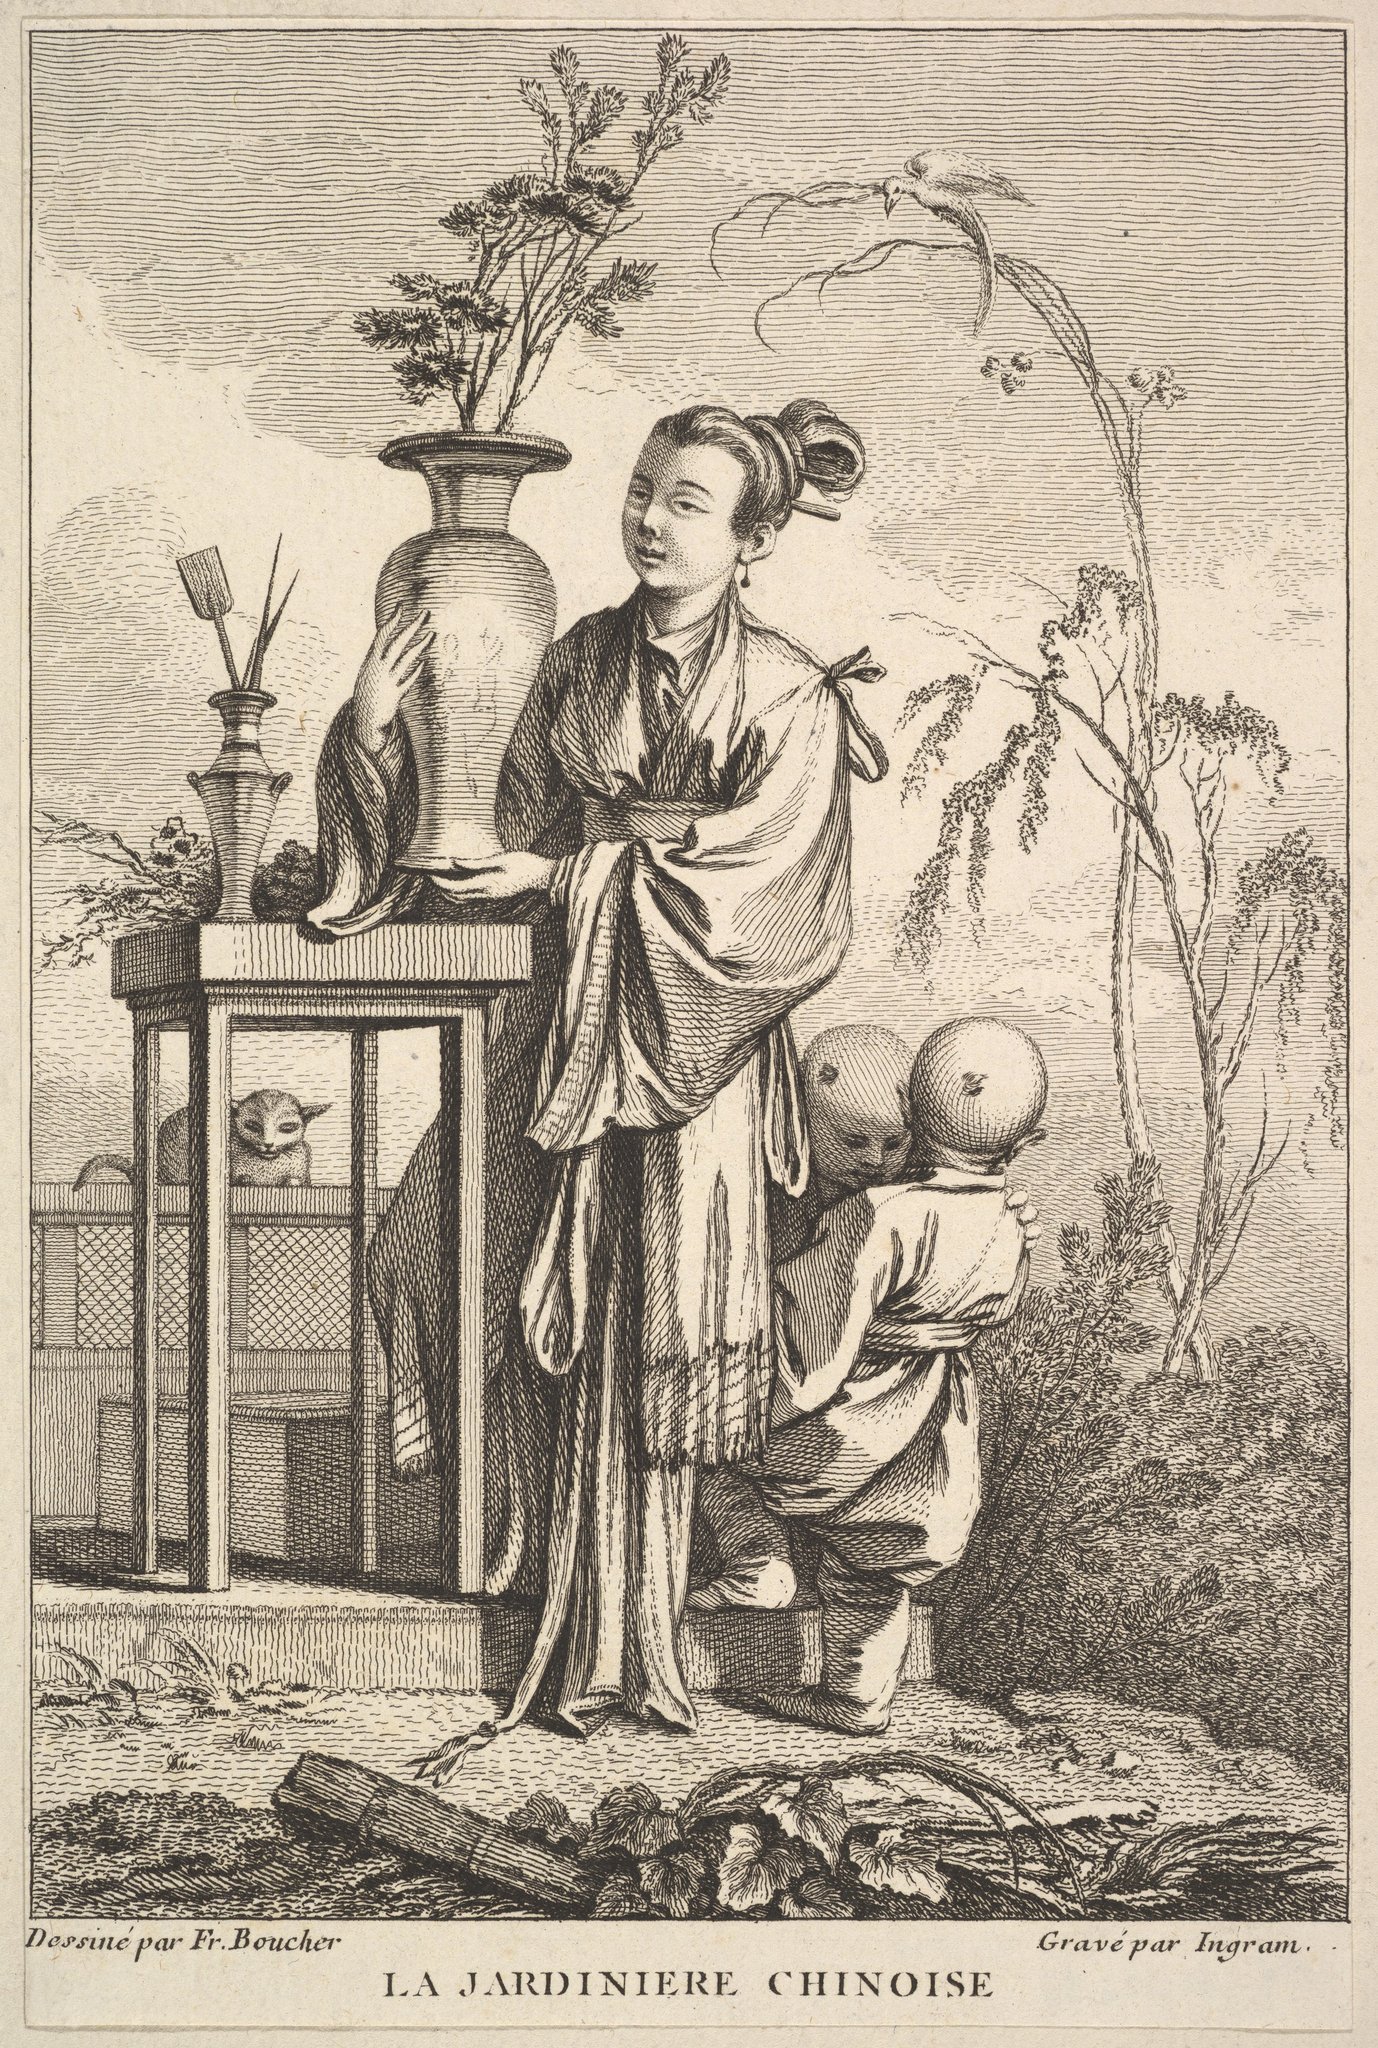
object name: print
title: The Chinese Gardener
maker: john ingram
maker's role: artist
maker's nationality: british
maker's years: 1721-1759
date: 1741-1763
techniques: engraving, etching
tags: children,women,cats,gardeners